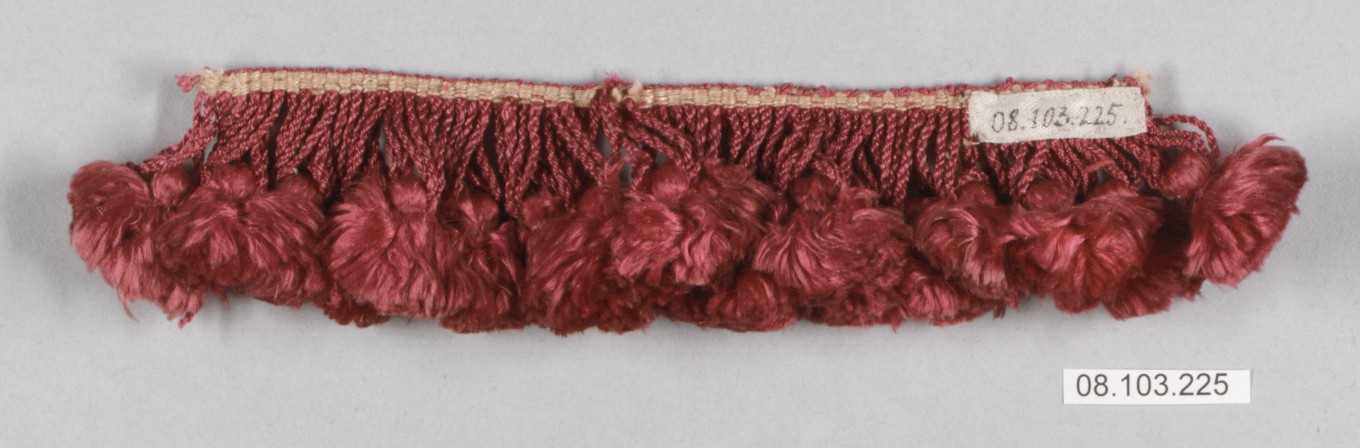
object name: fringe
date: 1701-1800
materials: silk